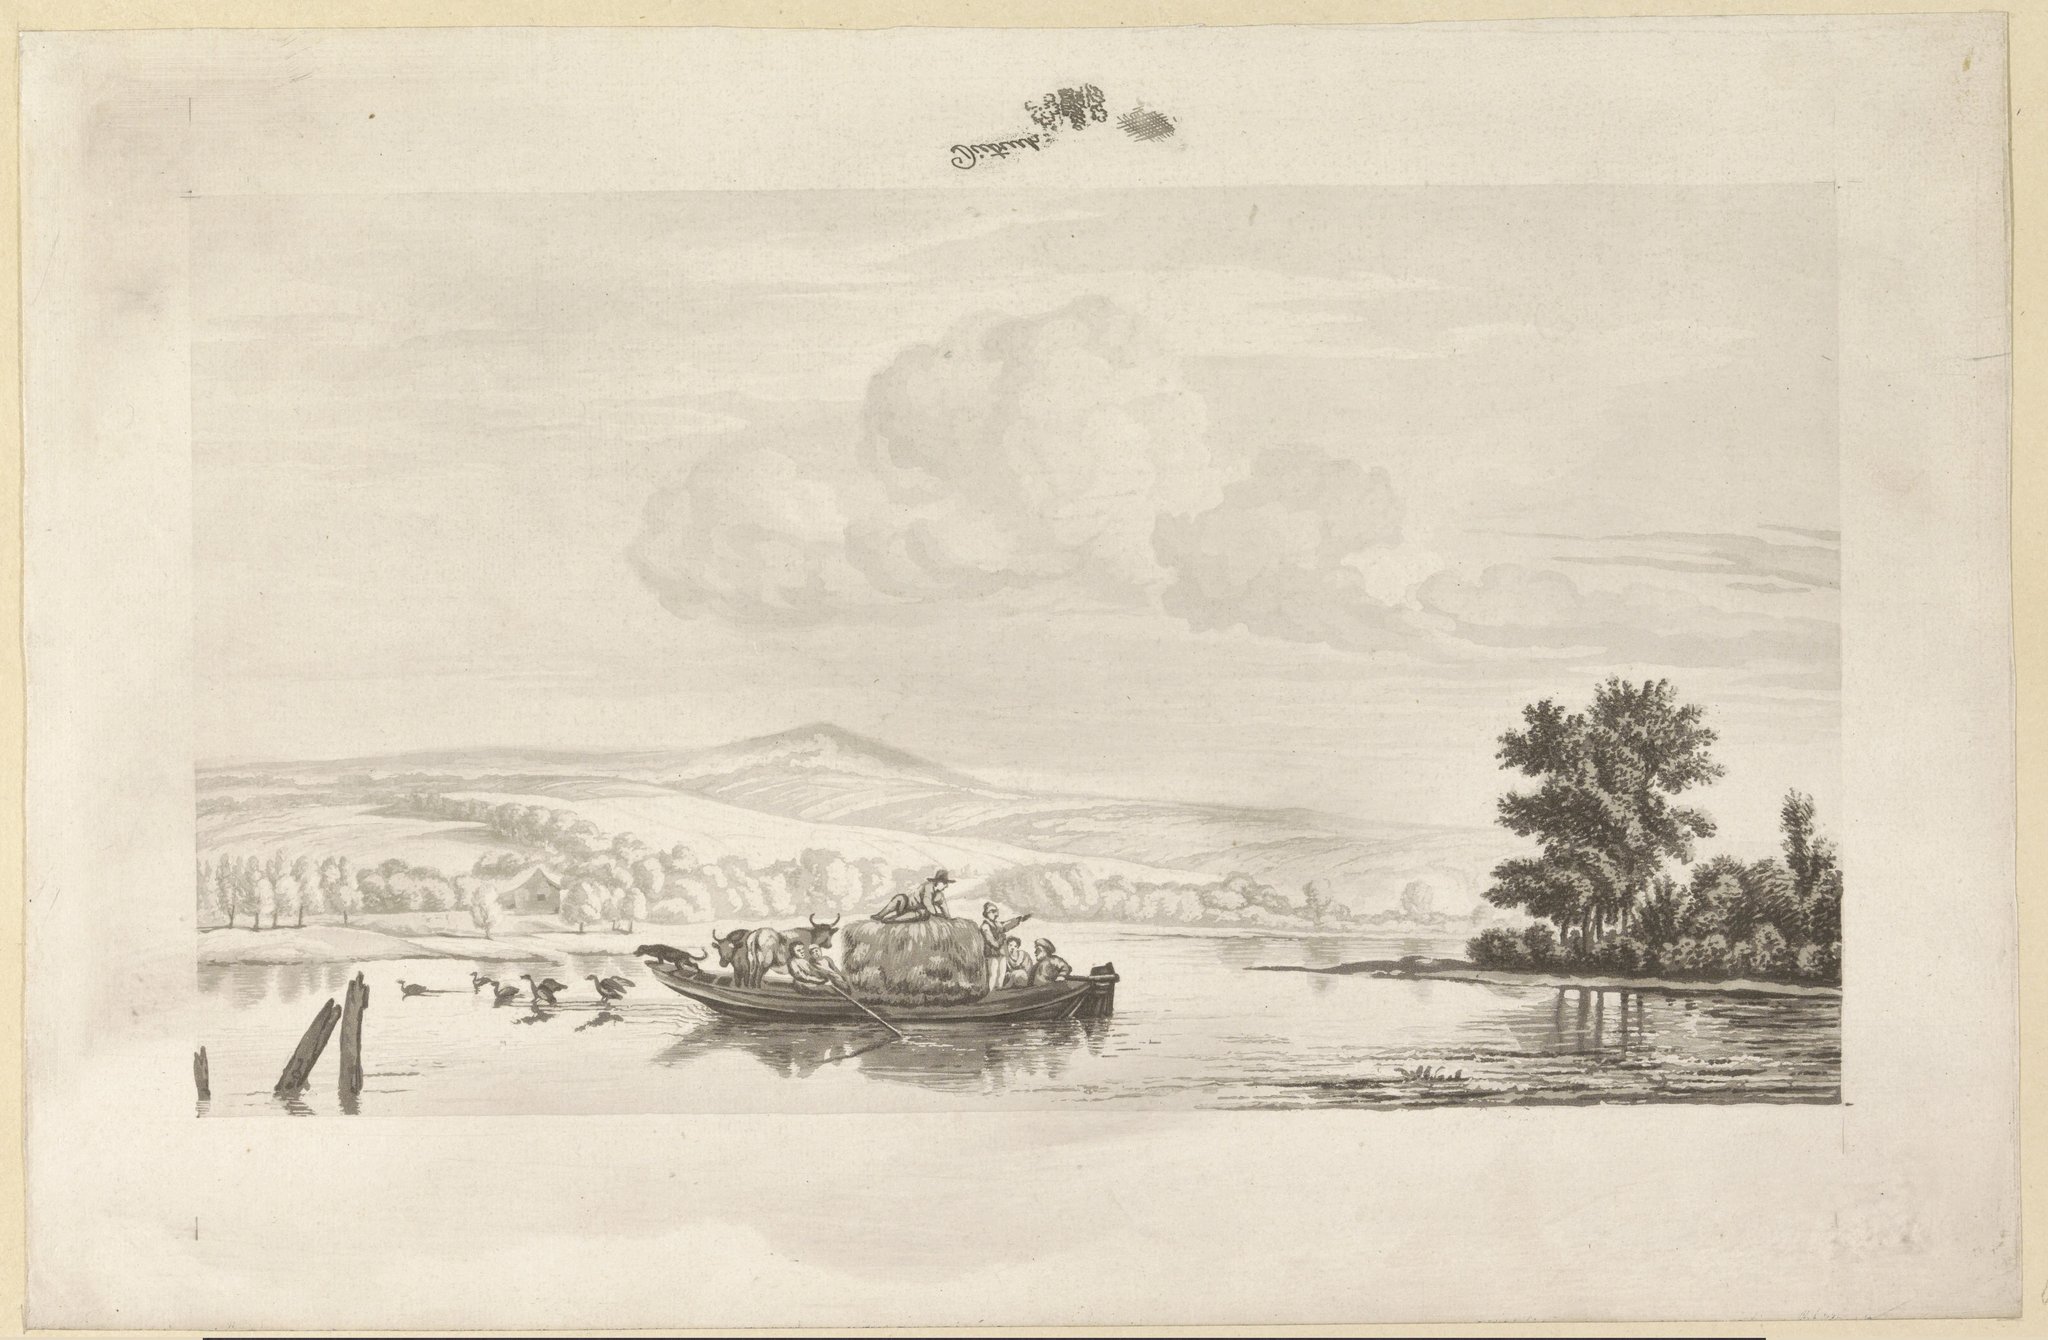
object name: print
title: Riviergezicht met hooischuit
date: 1795-1821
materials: paper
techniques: etching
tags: agricultural products and by-products: hay, ferry, landscapes (+ landscape with figures, staffage)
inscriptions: collector's mark: Lugt 2228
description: De voltooide prent werd opgenomen in: Collection d'imitations de dessins d'après les principaux maîtres hollandais et flamands, Londen, C. Josi, 1821.